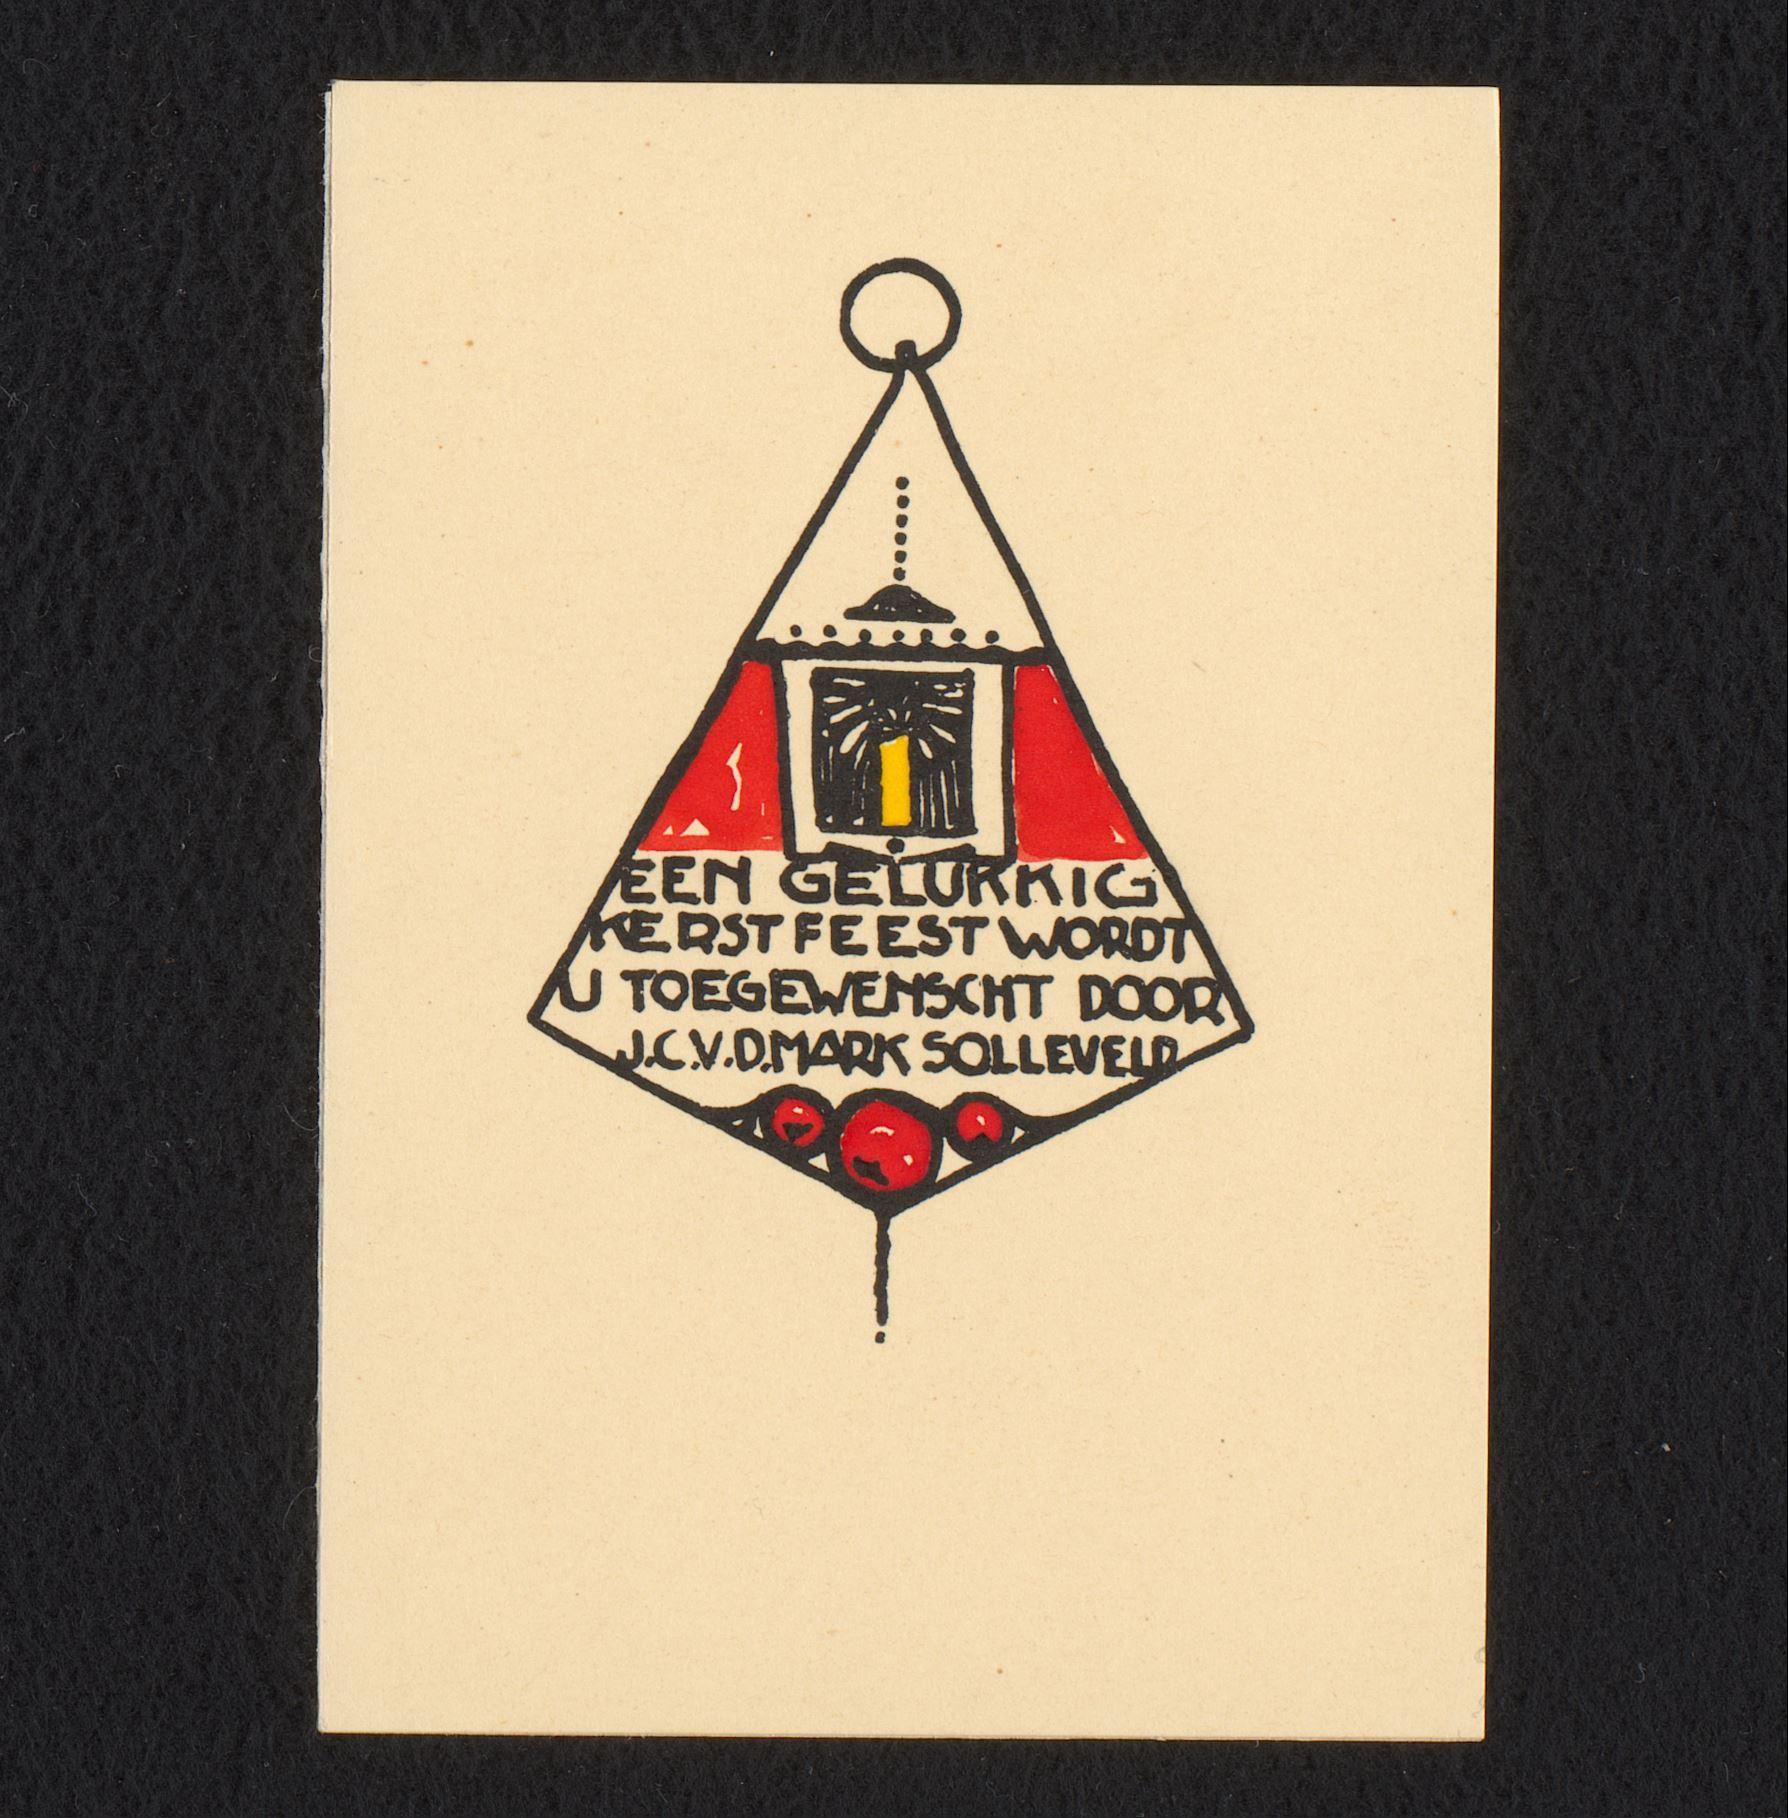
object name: christmas card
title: Kerstkaart van J.C. v.d. Mark Solleveld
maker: Anonymous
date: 1900-1935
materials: paper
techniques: woodcut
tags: christmas decorations, christmas card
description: Een kerstversiering met daarin de tekst: 'Een gelukkig kerstfeest wordt u toegewenscht door J.C.V.D. Mark Solleveld'.